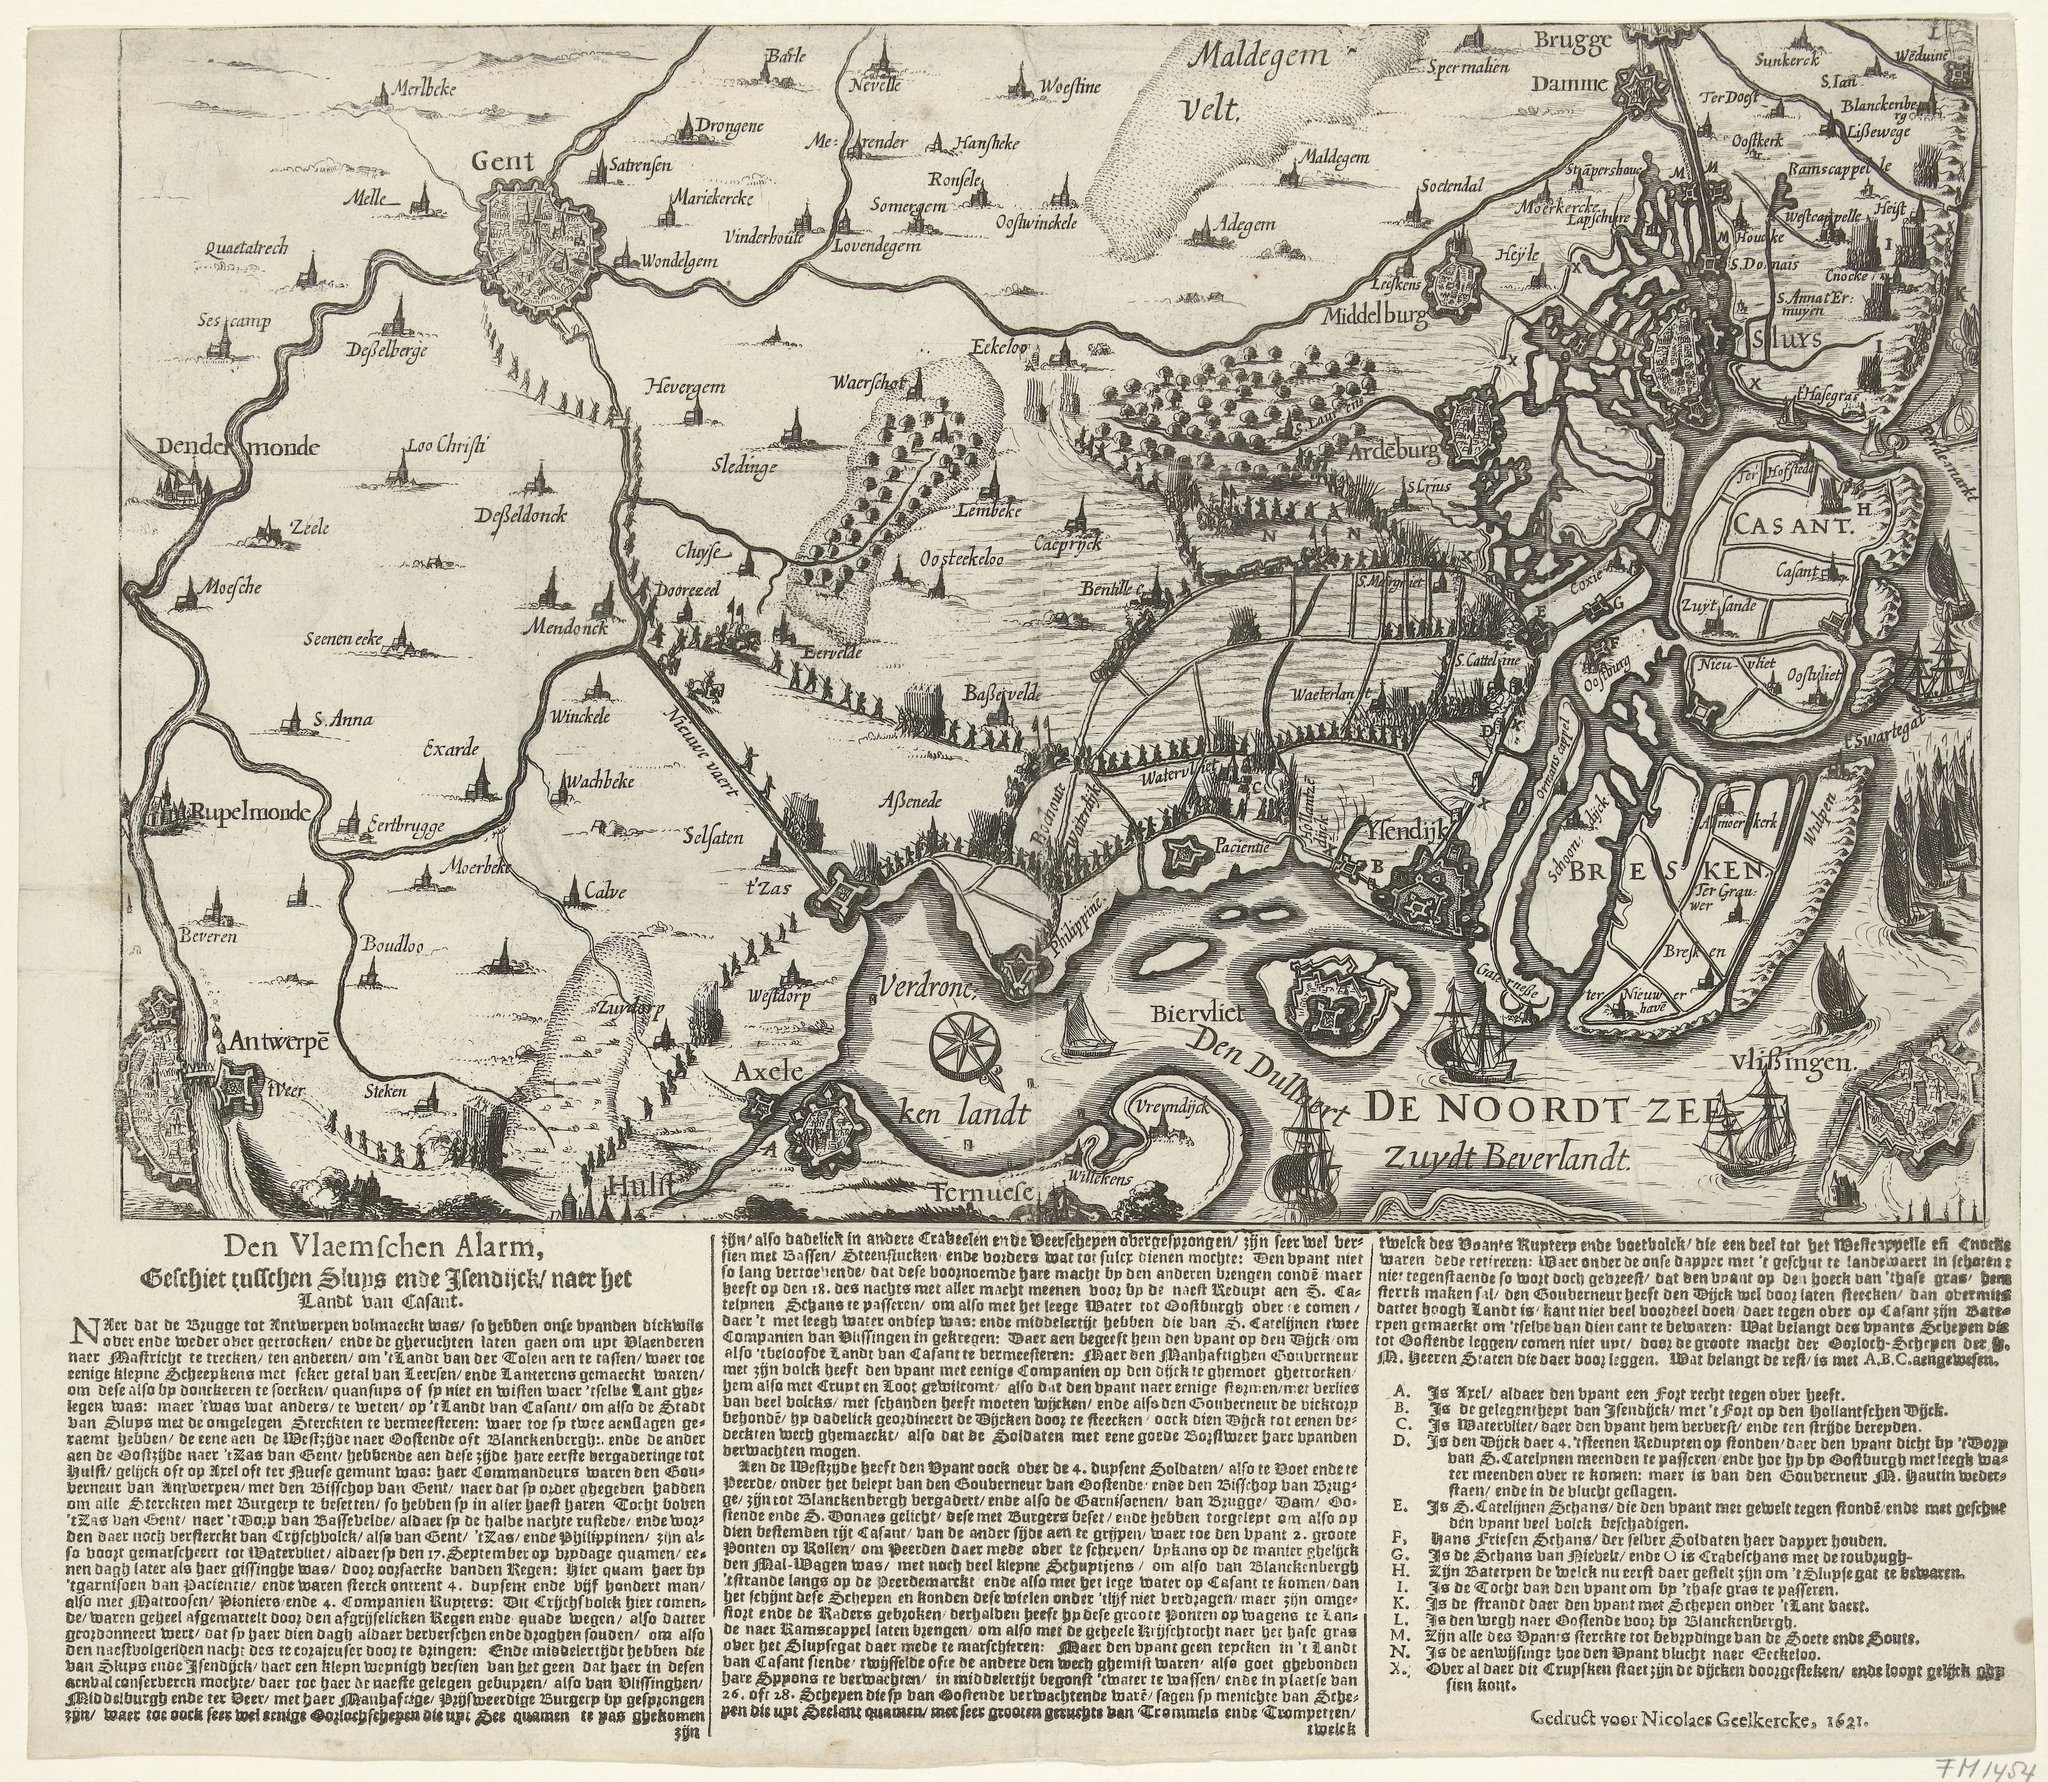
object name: map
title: Vlaamse Alarm, 1621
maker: nicolaes van geelkercken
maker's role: print maker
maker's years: 1585-1656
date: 1621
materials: paper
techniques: etching, letterpress printing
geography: leiden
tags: maps of separate countries or regions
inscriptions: date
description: Kaart van Zeeuws-Vlaanderen van Antwerpen tot Sluis en Cadzand. Het Spaanse leger trekt op naar Cadzand in een poging om Sluis te overmeesteren, 17-18 september 1621. Onder de voorstelling een beschrijving van de gebeurtenissen en de legenda A-X in 3 kolommen in het Nederlands.